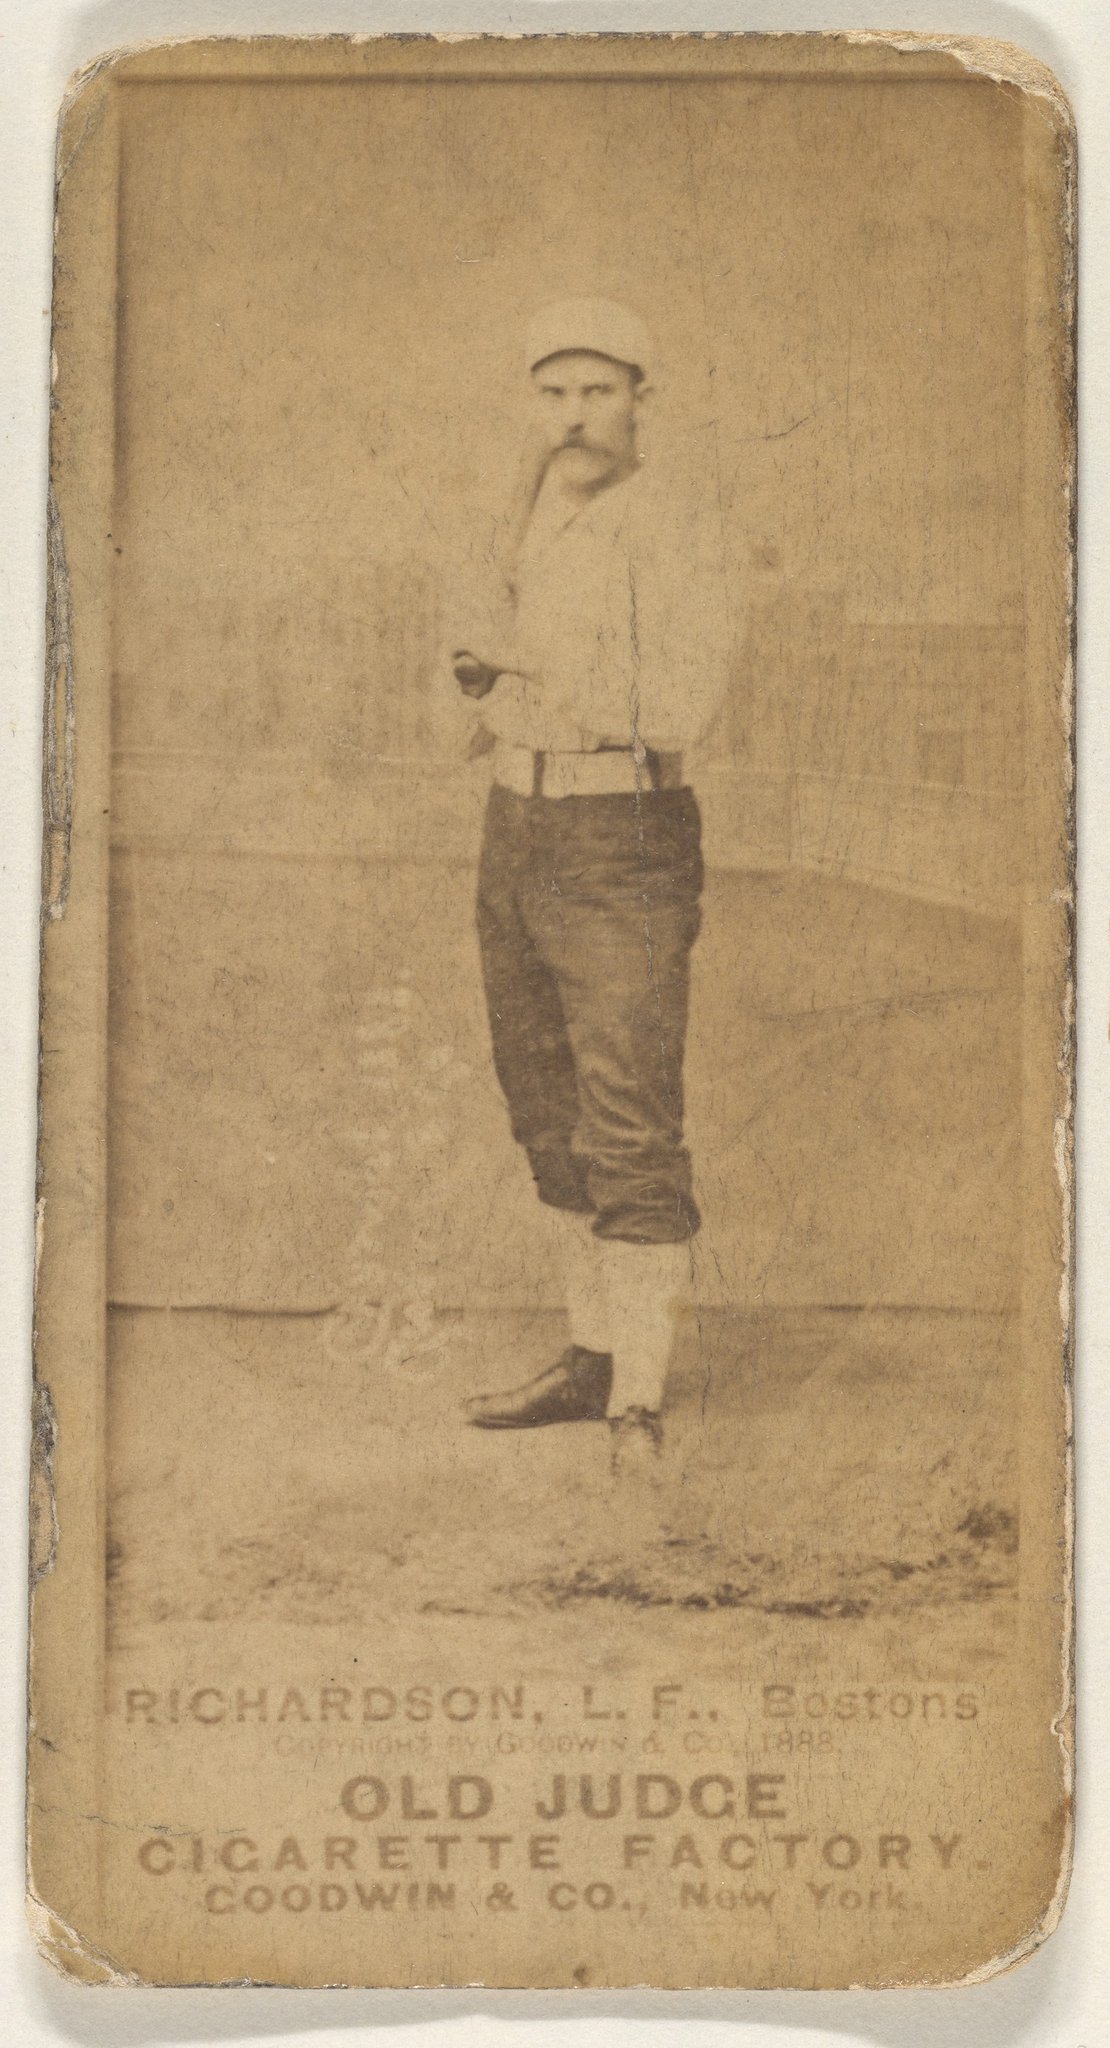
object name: baseball card, photograph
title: Richardson, Left Field, Boston, from the Old Judge series (N172) for Old Judge Cigarettes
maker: goodwin & company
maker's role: publisher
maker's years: 1850-1950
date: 1888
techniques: albumen silver print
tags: men,portraits,baseball,athletes